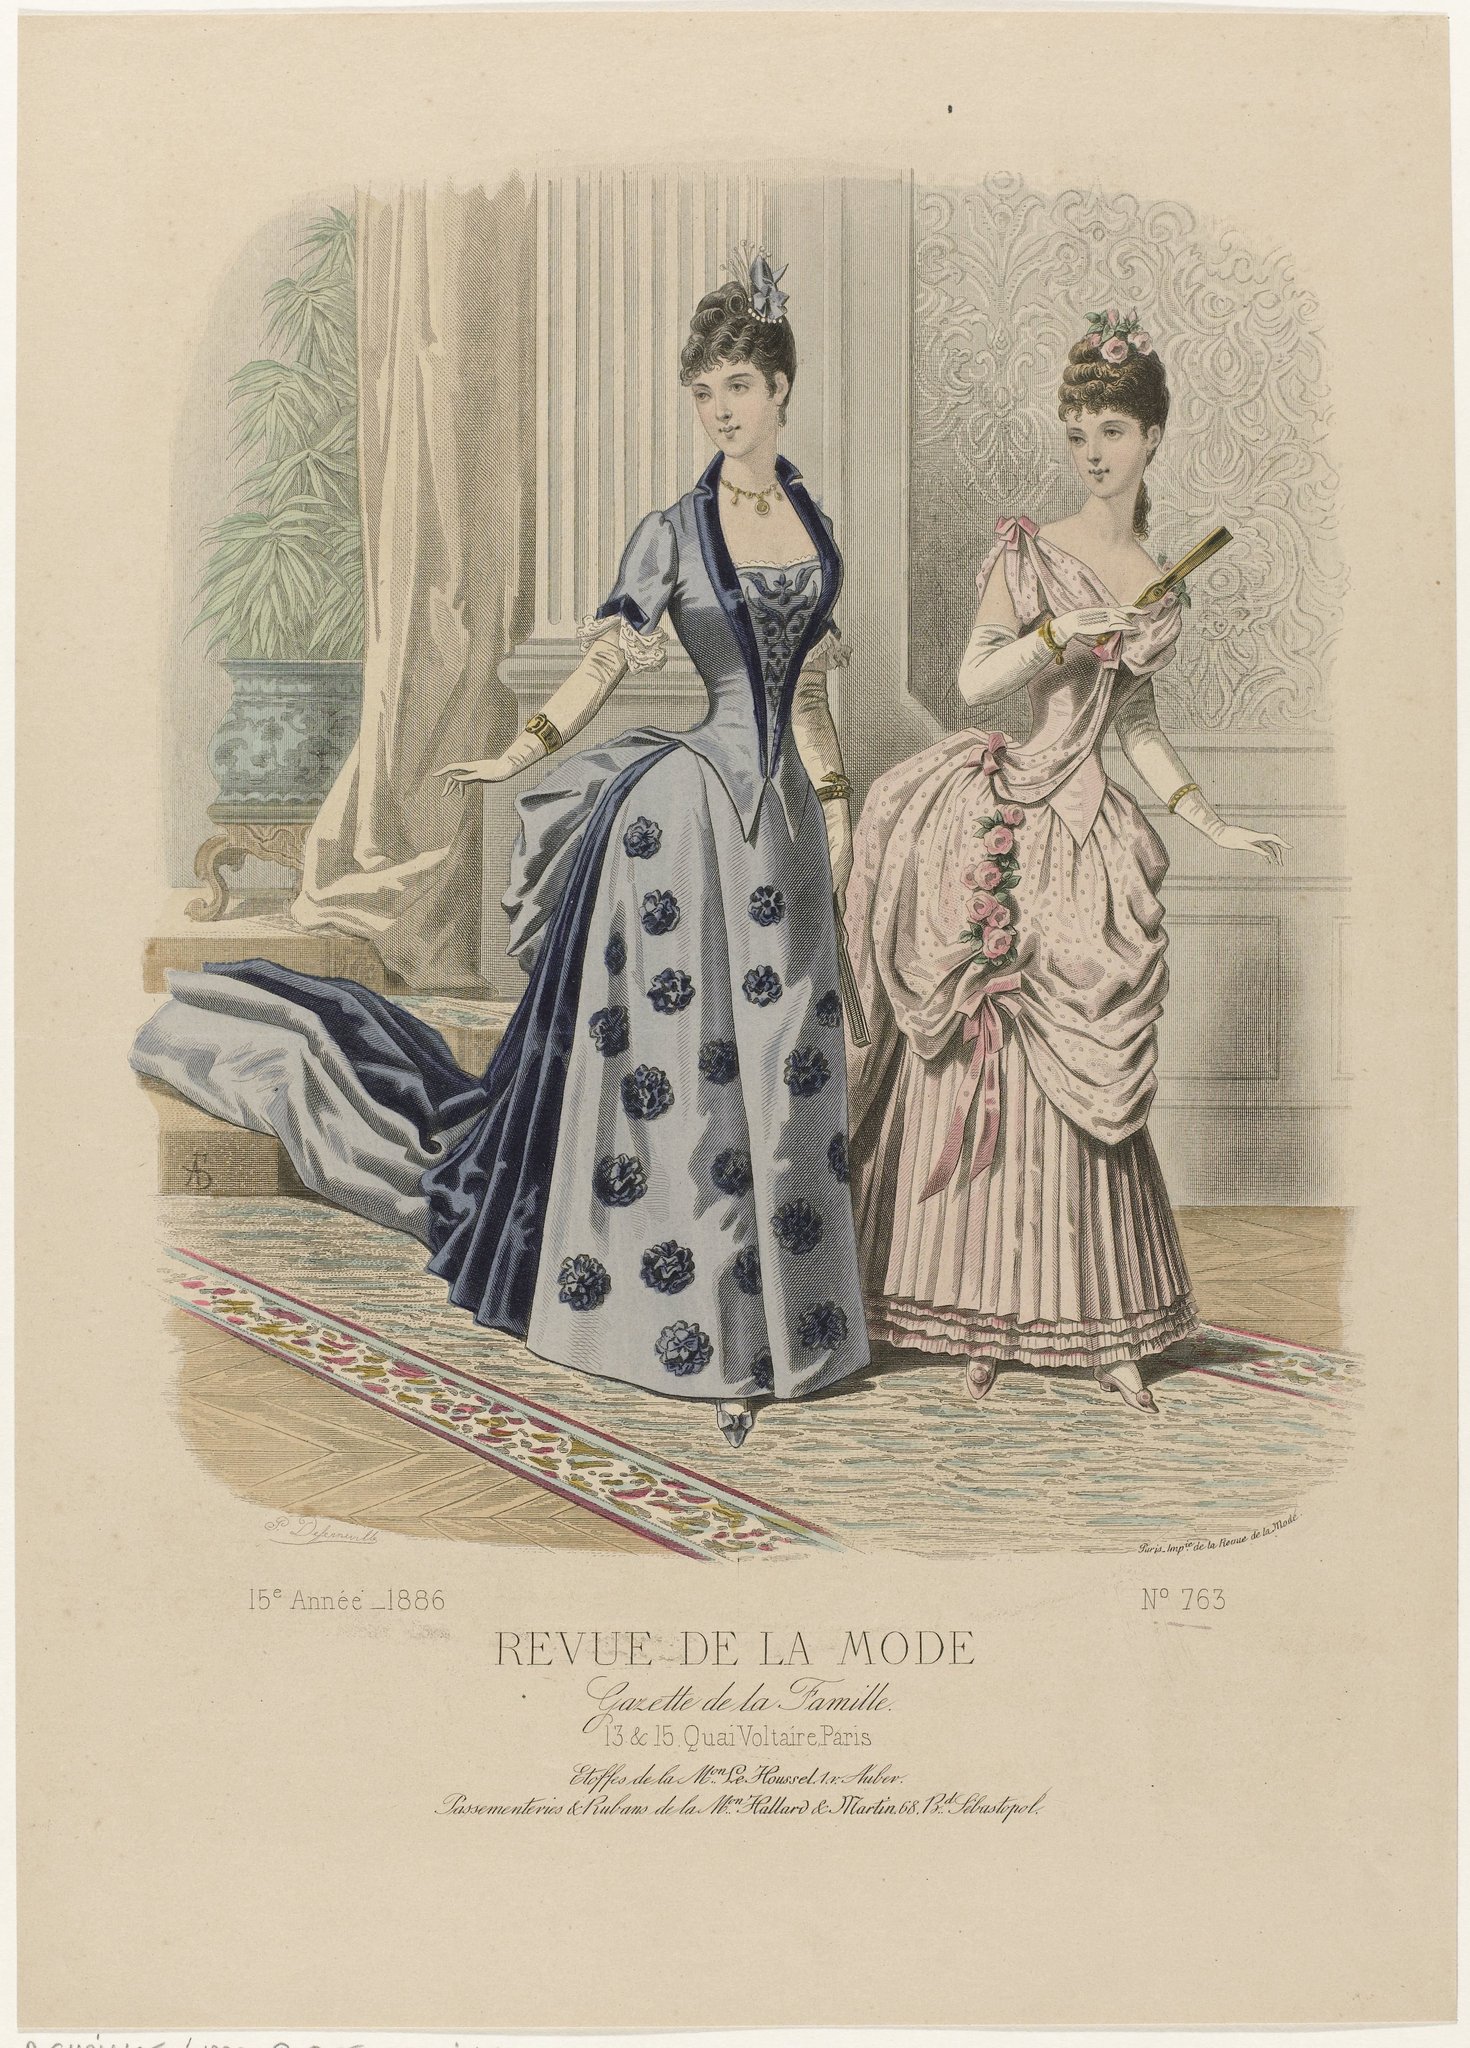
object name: fashion print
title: Revue de la Mode, Gazette de la Famille, dimanche 15 août 1886, 15e Année, No. 763: Etoffes de la M.on Le Houssel (...)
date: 1886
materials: paper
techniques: engraving, hand coloring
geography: paris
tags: corsage (+ women's clothes), gloves, mittens (long gloves) (+ women's clothes), dress, gown: ball gown (+ women's clothes), lace (+ women's clothes), fashion plates, fan (+ women's clothes), flowers: rose, bracelet, wristlet (+ women's clothes), necklace (+ women's clothes)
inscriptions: address: ‘13 & 15, Quai Voltaire Paris’, caption: ‘Etoffes de la M.on Le Houssel 1 r. Auber. Passementeries & Rubans de la M.on Hallard & Martin, 68, B.d Sébastopol.’, title: ‘REVUE DE LA MODE / Gazette de la Famille’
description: Twee vrouwen in een interieur. Links: 'toilette' van gebrocheerde zijde, effen zijde en fluweel. Korte mouwen afgezet met fluweel en versierd met volant van kant. Rechts: 'toilette' voor een bal van roze zijde en gaas. 'Tunique' (overrok) versierd met guirlande van rozen. Onder de voorstelling enkele regels reclametekst voor verschillende producten. Prent uit het modetijdschrift Revue de la Mode (1872-1913). Uitgebreide beschrijving van de kleding op pagina 258 "PLANCHE COLORIÉE".